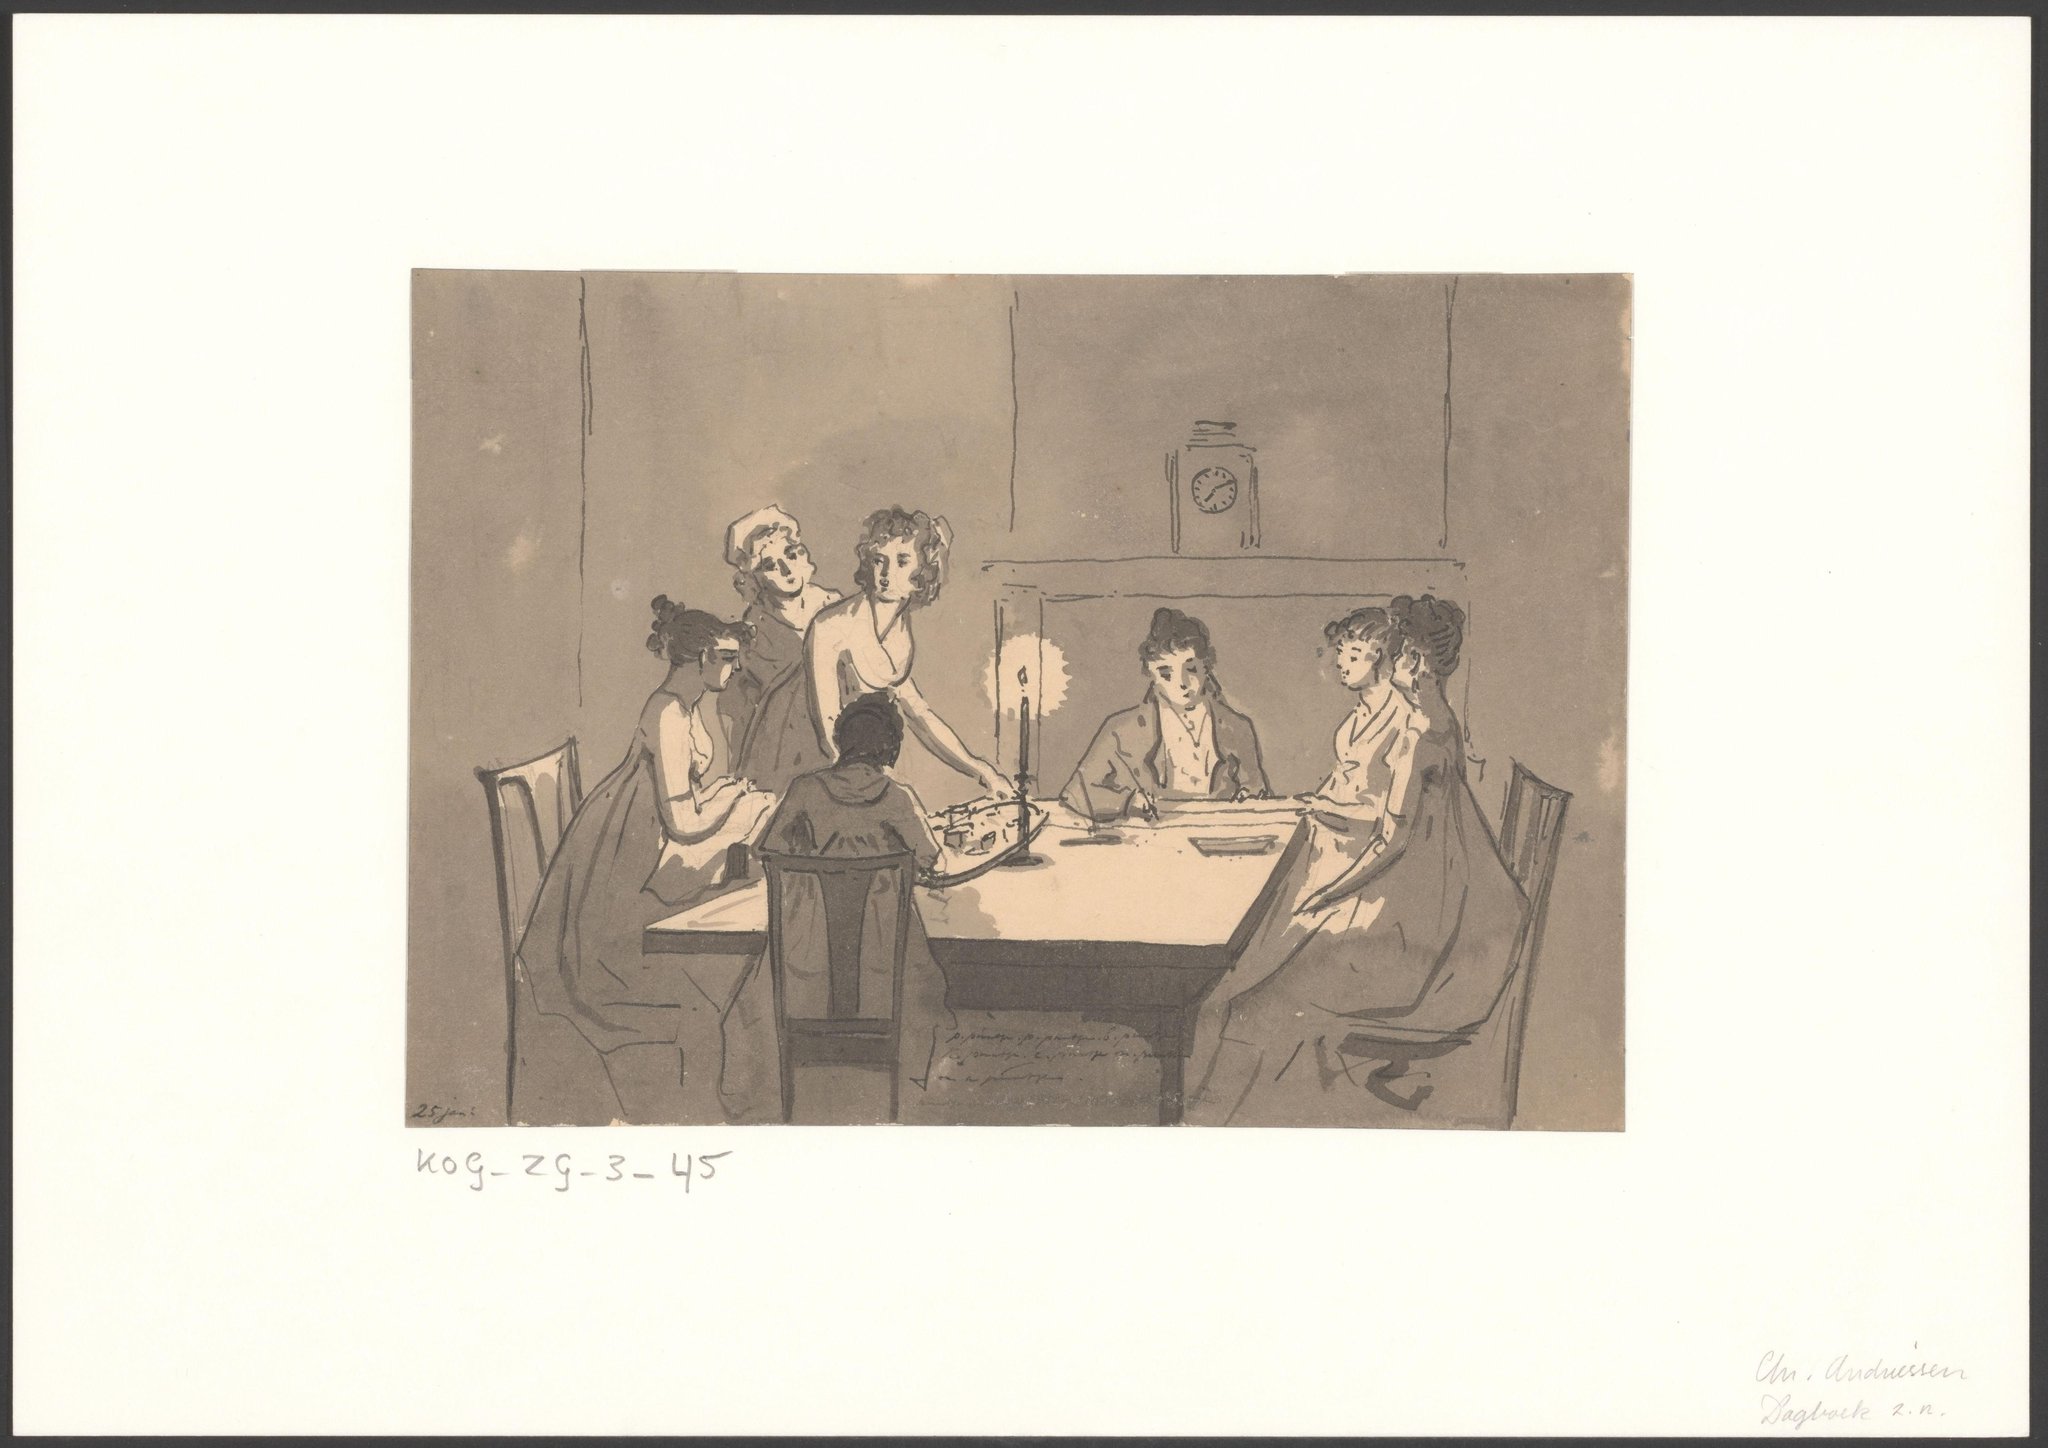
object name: drawing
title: Christiaan Andriessen geeft tekenles aan zes vrouwen bij kaarslicht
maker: christiaan andriessen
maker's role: draughtsman, print maker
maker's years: 1775-1846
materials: ink, paper, pencil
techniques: brush, pen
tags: table, candle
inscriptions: inscription: ‘J Andriessen’, inscription: ‘25 jan’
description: Christiaan Andriessen geeft tekenles aan zes vrouwen bij kaarslicht. Op verso zes gezichten van vrouwen.